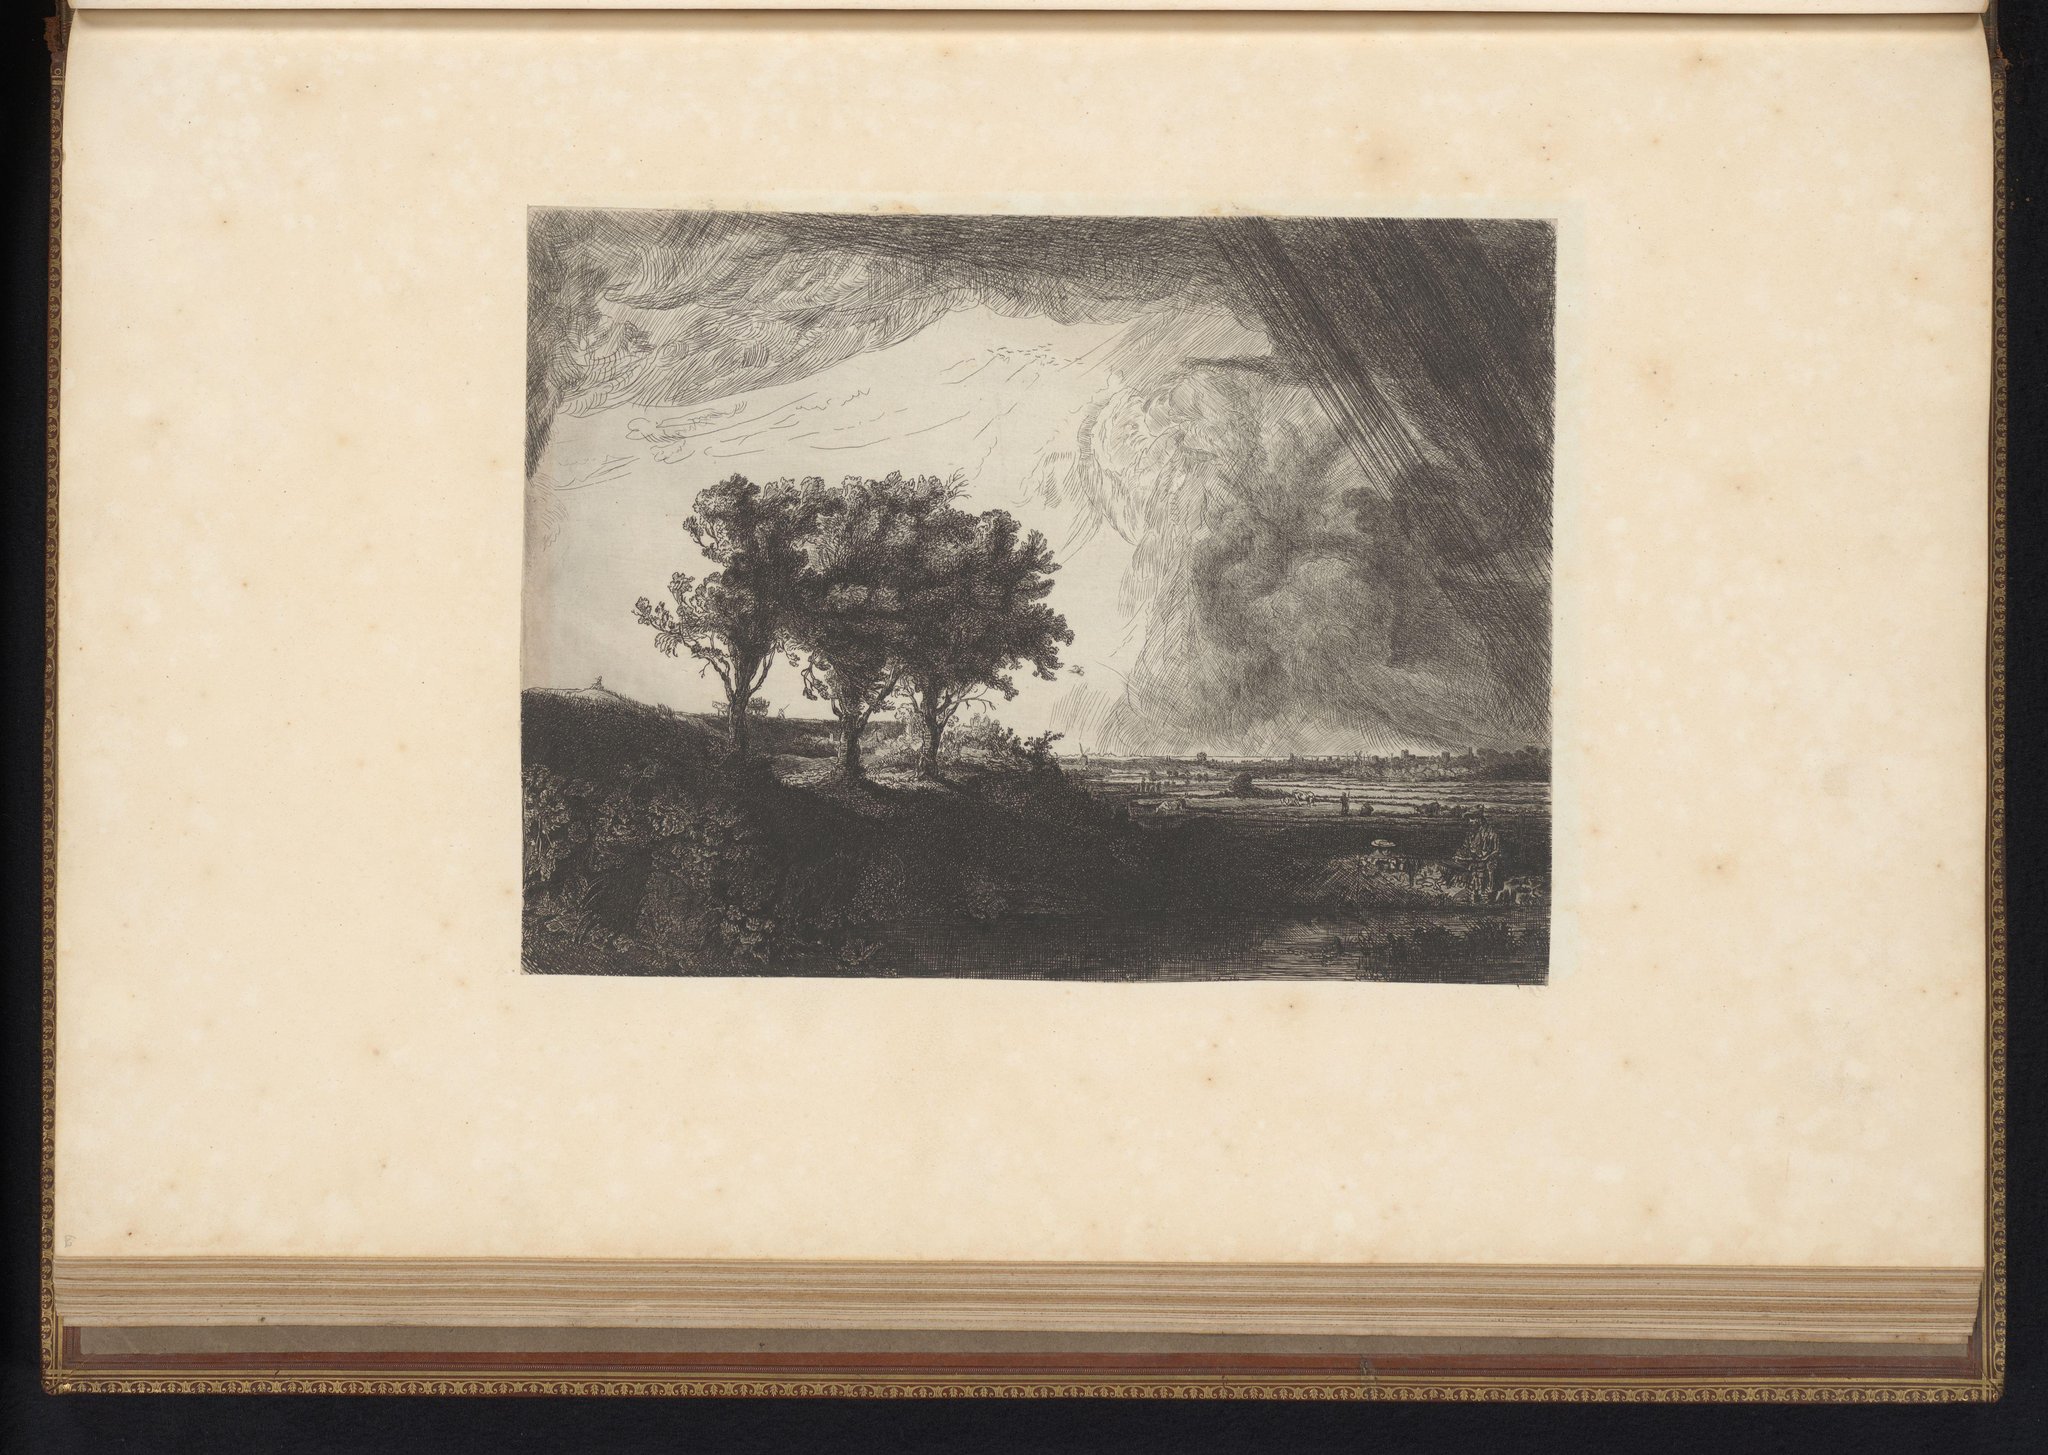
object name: album leaf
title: Drie bomen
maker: william baillie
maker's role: print maker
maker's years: 1723-1810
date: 1753-1810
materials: paper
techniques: drypoint, etching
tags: groups of trees